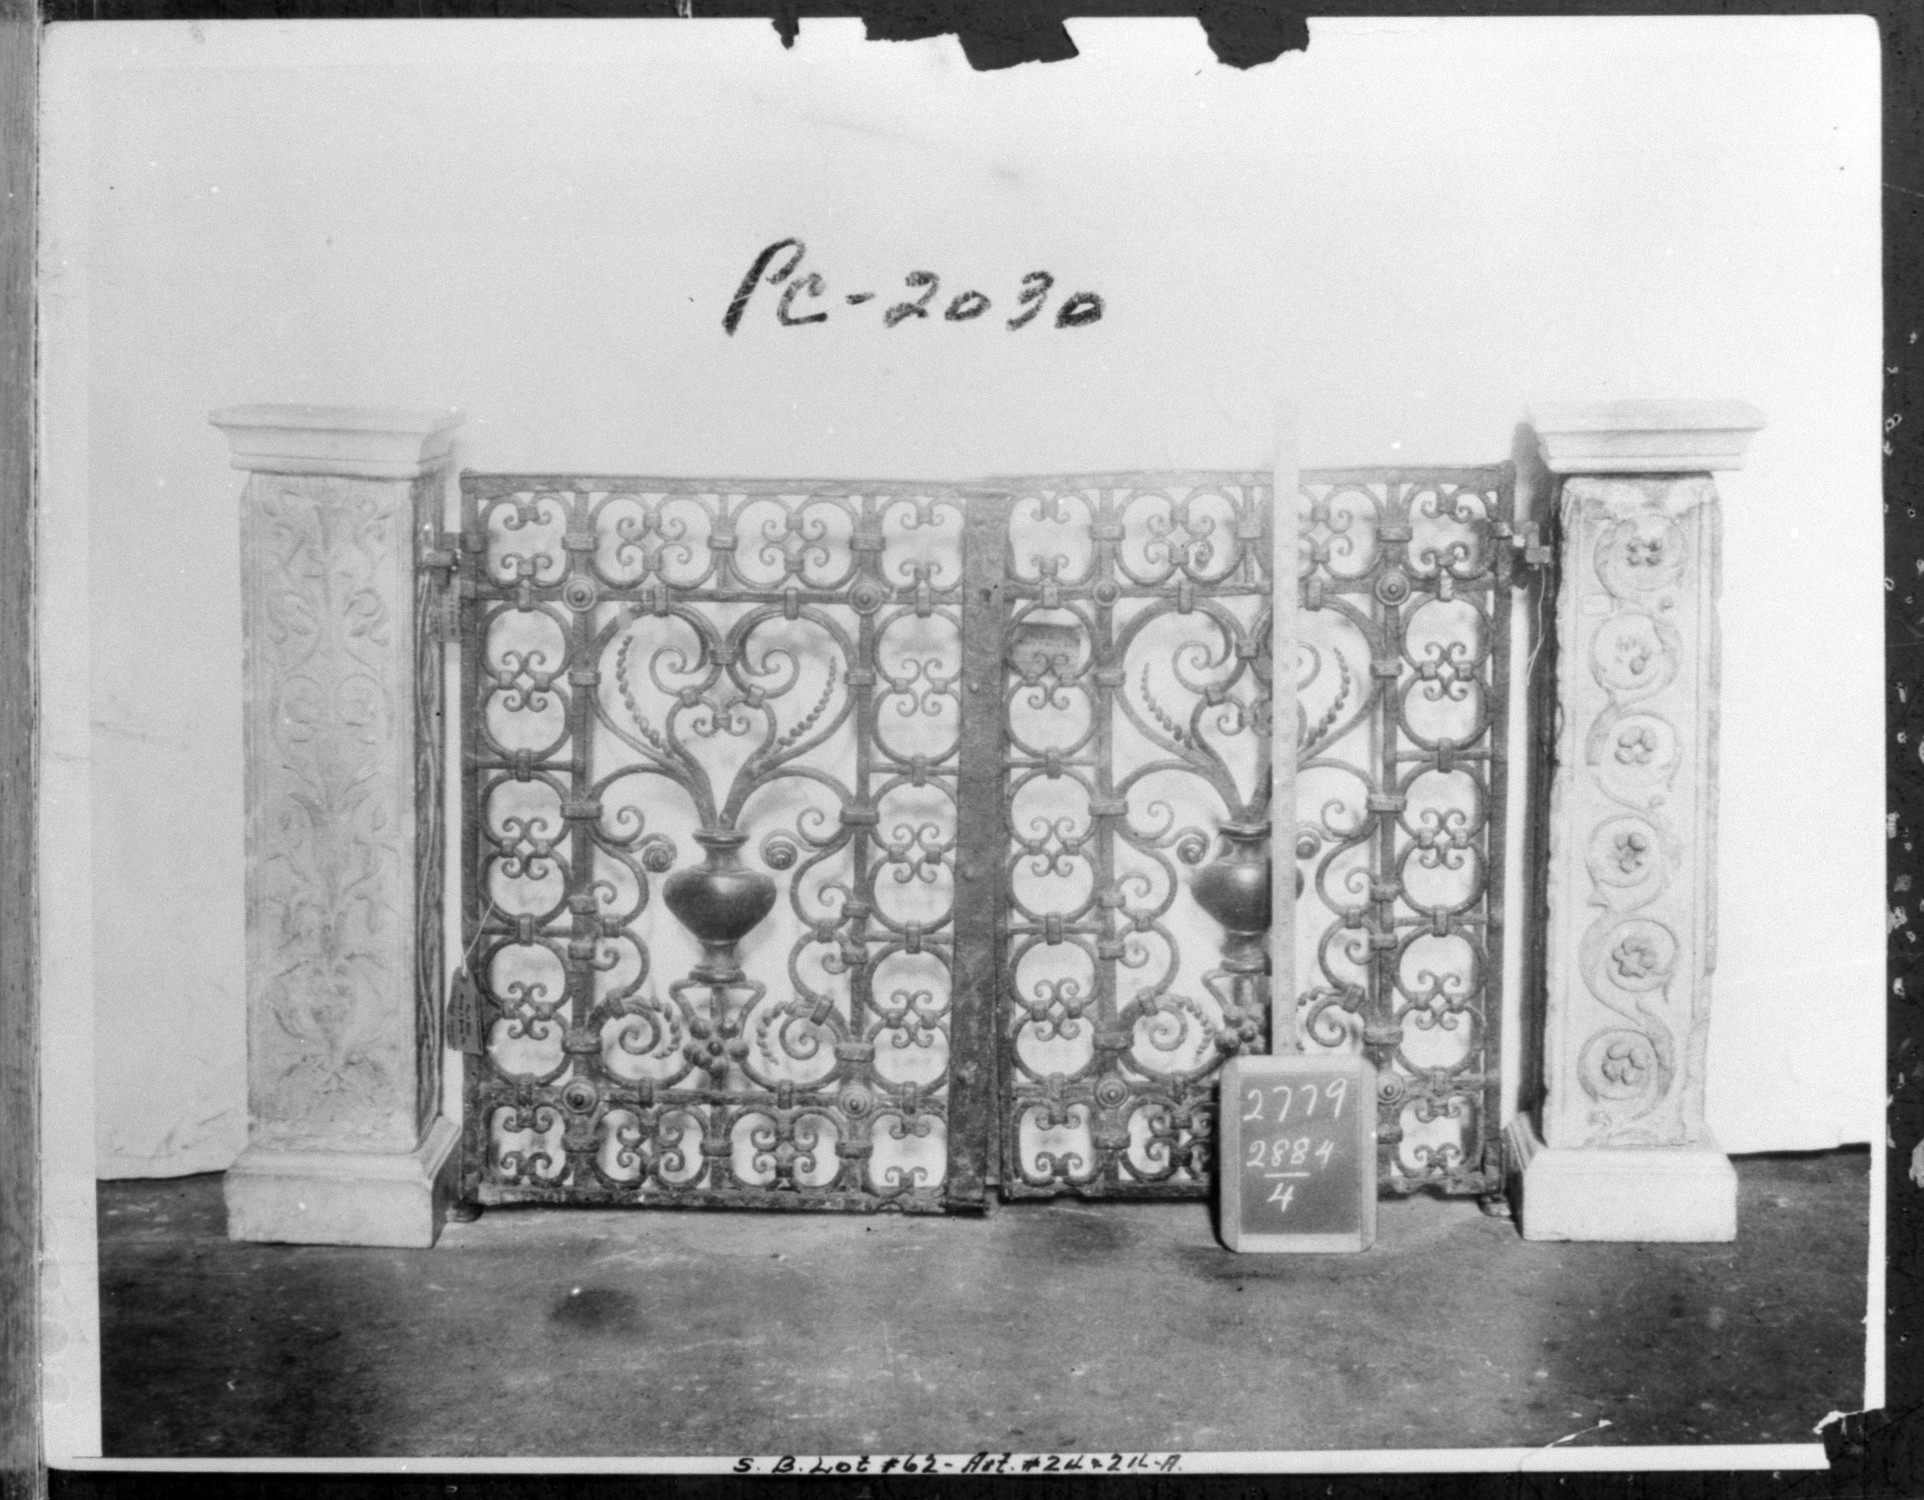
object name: gate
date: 1601-1700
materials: iron, marble